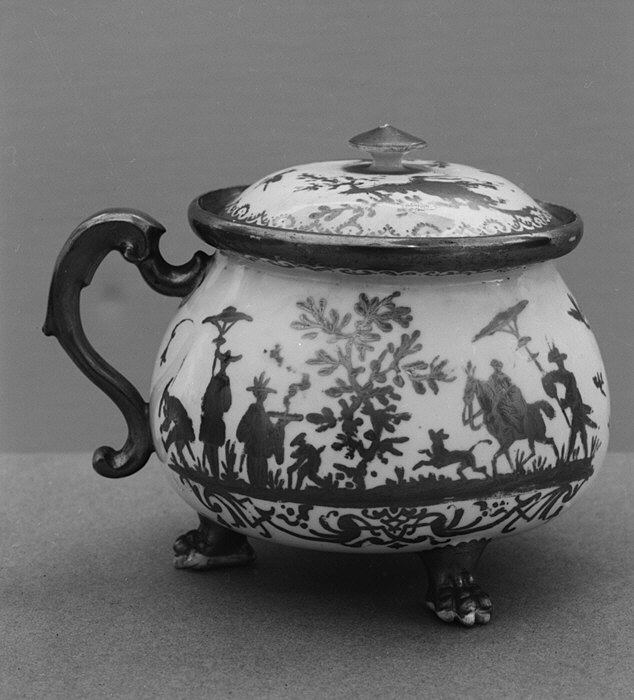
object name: bowl with cover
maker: meissen manufactory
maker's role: manufactory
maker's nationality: german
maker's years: 1710-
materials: hard paste porcelain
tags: human figures,horses,trees